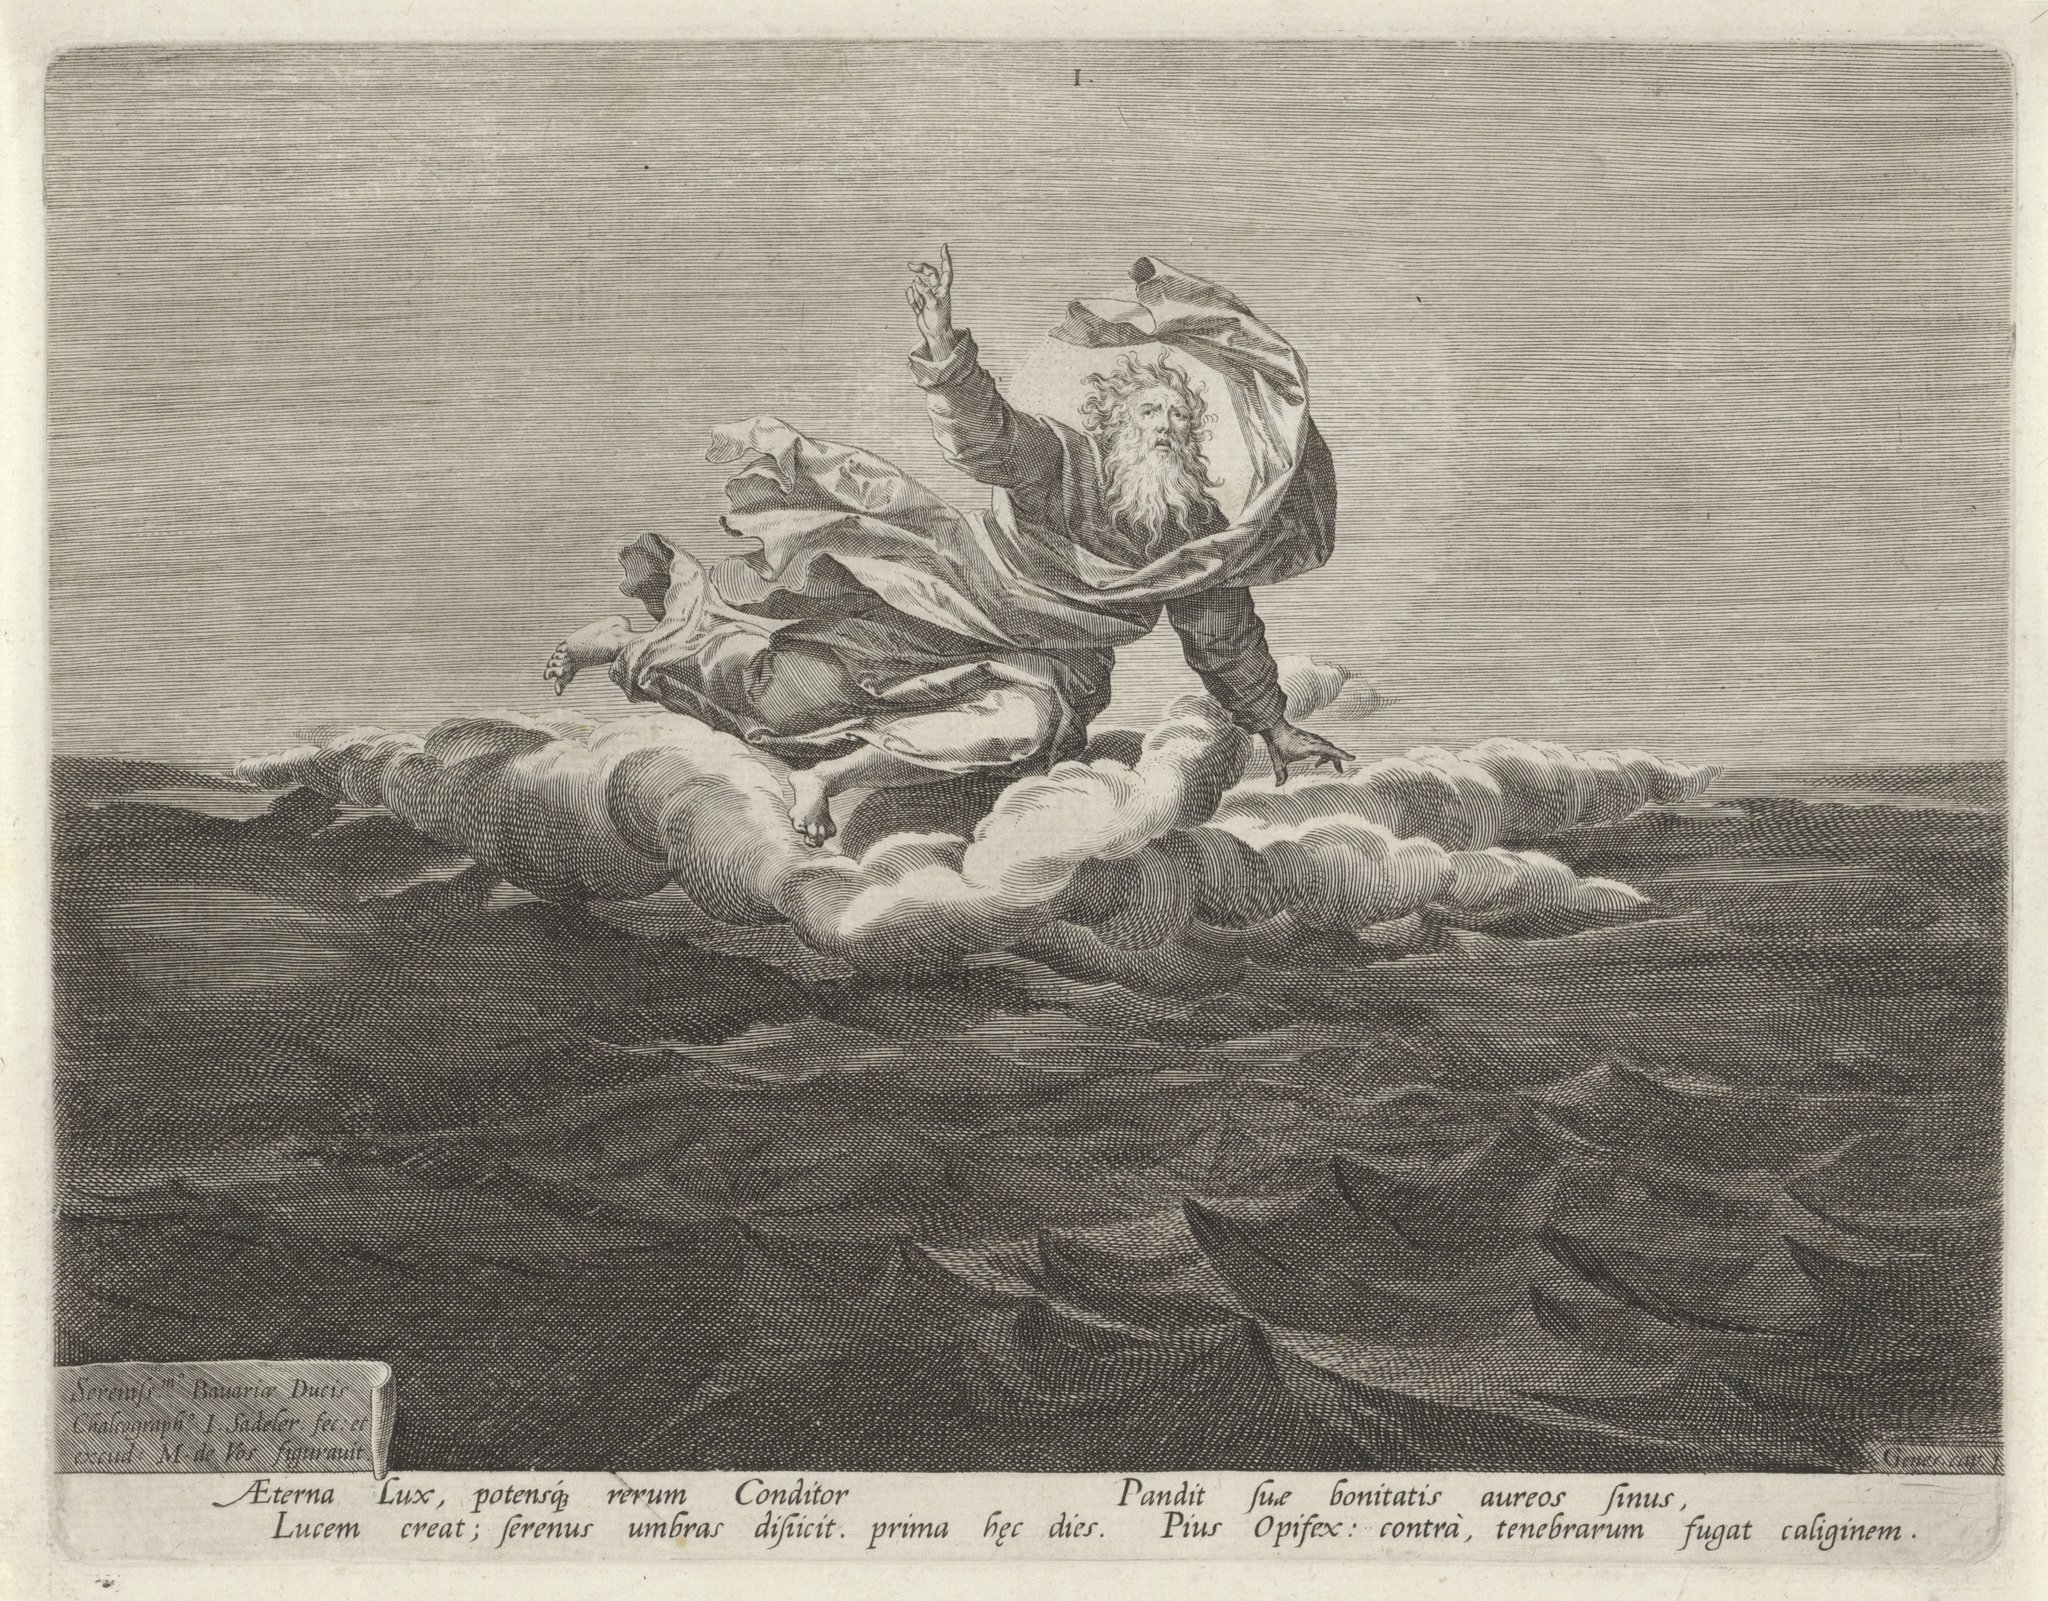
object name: print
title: Schepping van de wereld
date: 1588-1600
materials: paper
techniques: engraving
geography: munich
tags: division of light and darkness, god the father as bearded old man, usually with crown or tiara or sceptre and/or globe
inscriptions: collector's mark: Lugt 240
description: God de Vader zweeft op een wolk: boven hem is er licht, onder hem duisternis. Op de eerste dag van de schepping schiep God licht en duisternis. De prent heeft een Latijns onderschrift.